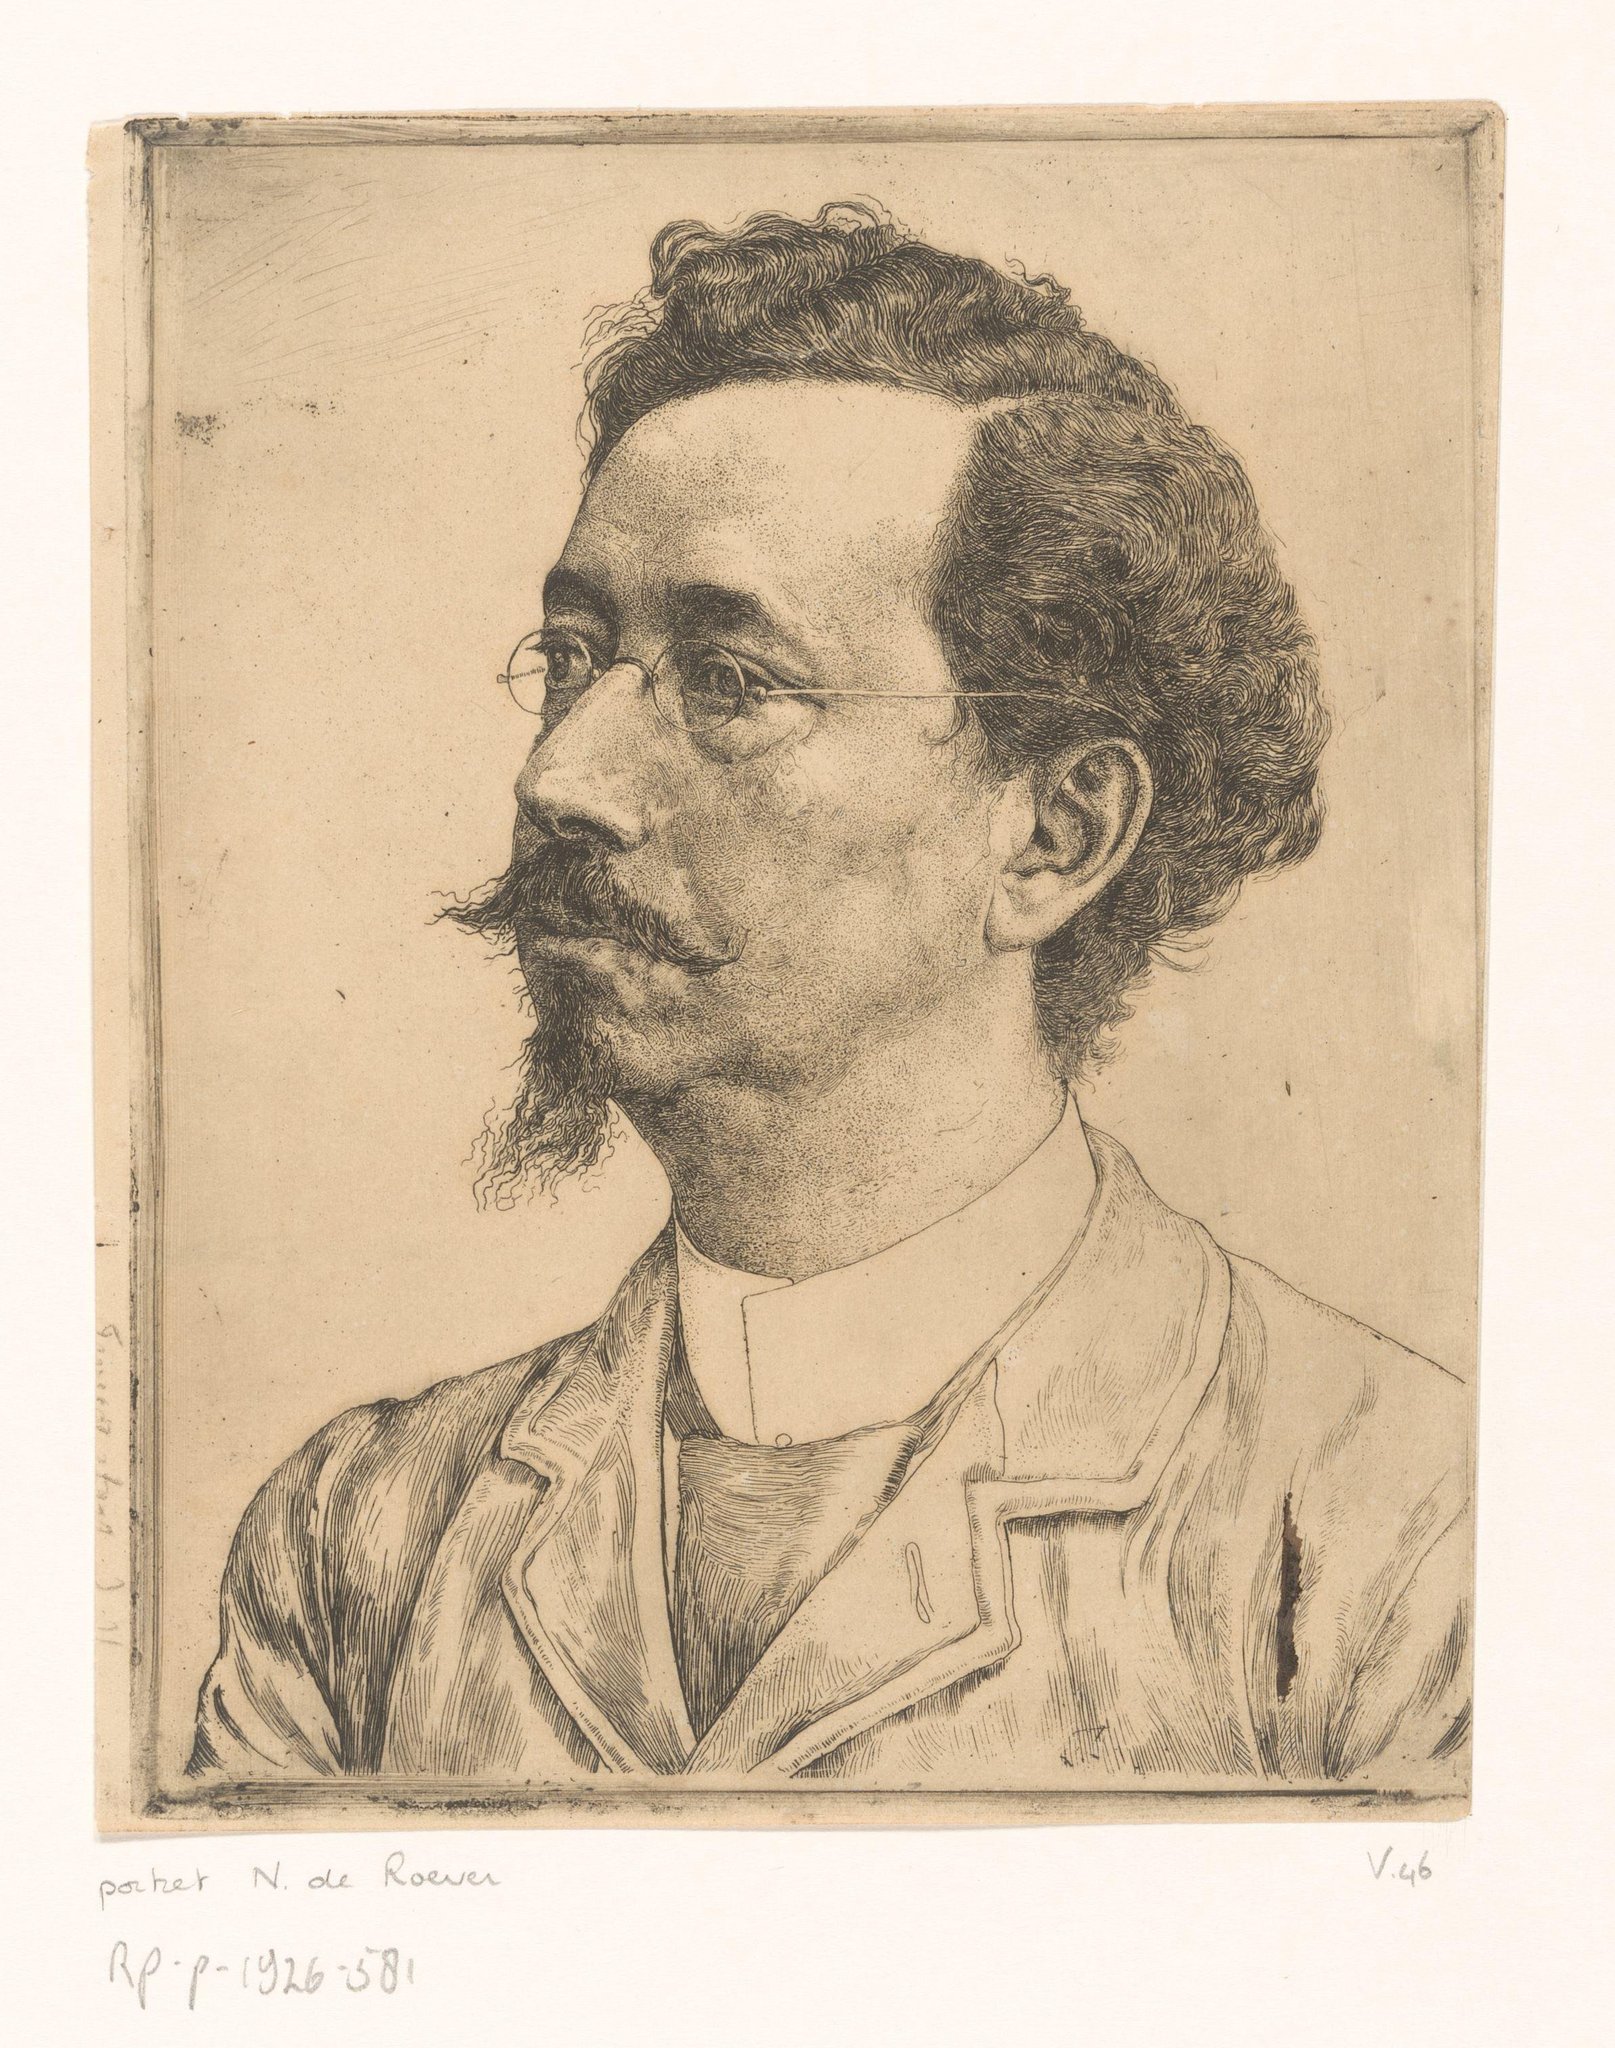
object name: print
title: Portret van Nicolaas de Roever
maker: jan veth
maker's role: designer, draughtsman, painter, print maker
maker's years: 1864-1925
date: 1893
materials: paper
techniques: drypoint, etching, intaglio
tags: historical persons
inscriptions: collector's mark: Lugt 2228